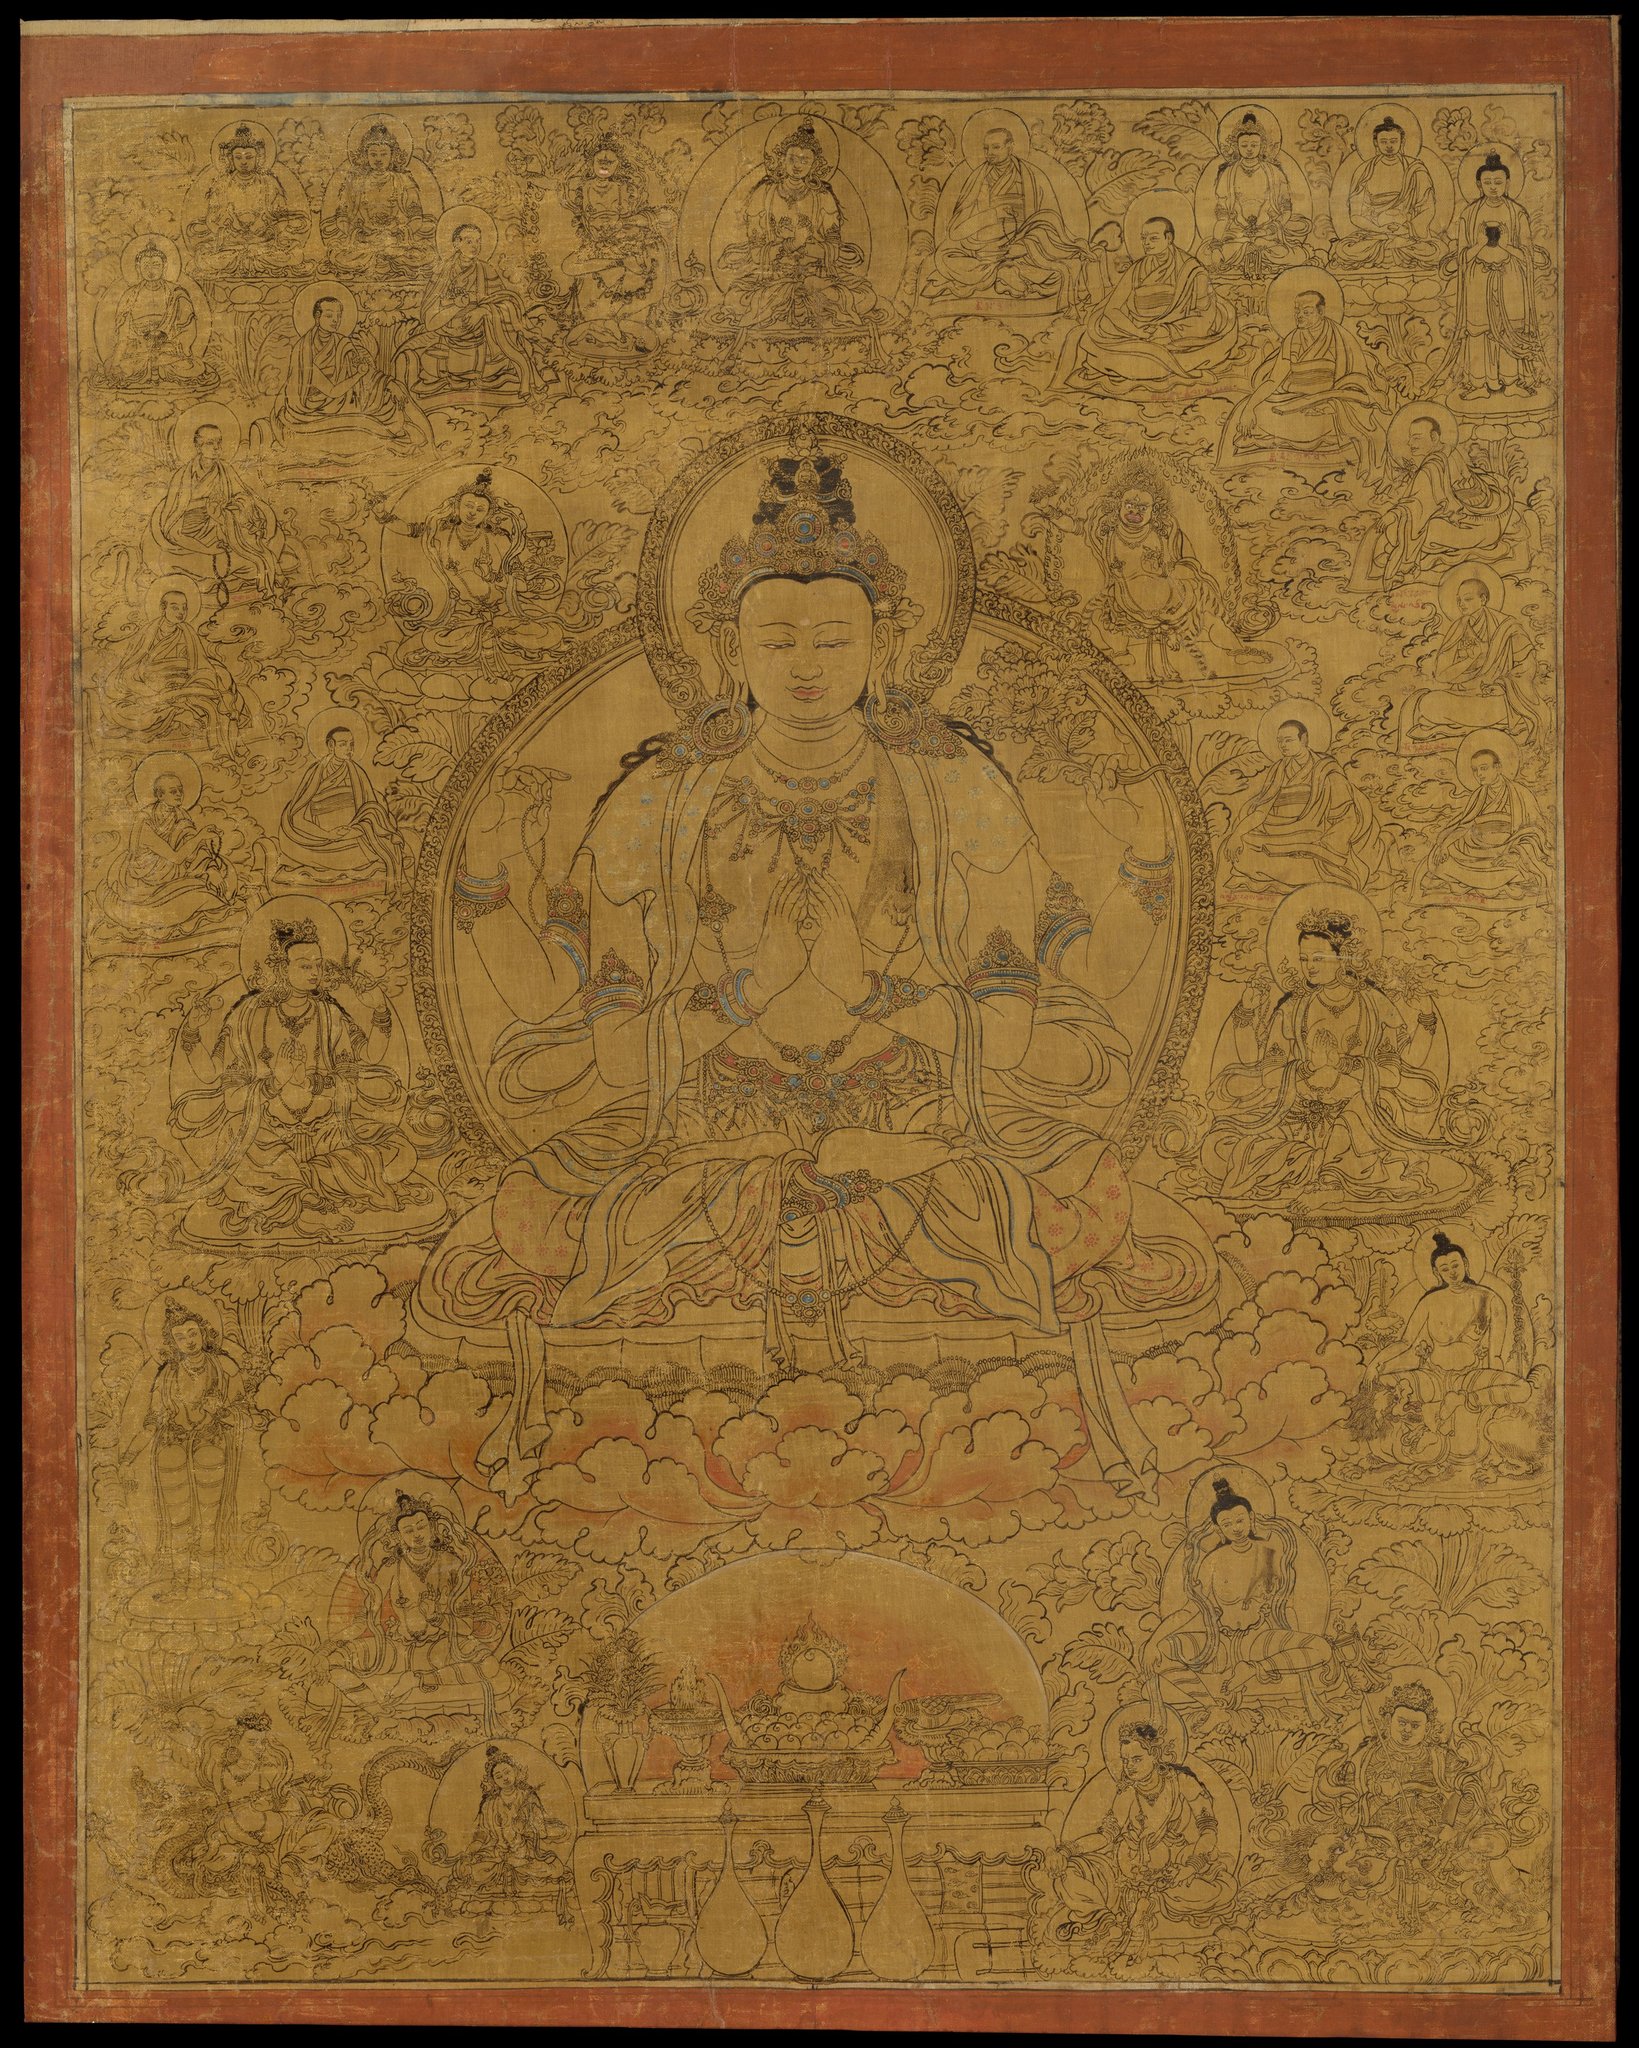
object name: painting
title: Sadaksari-Lokeshvara Surrounded by Manifestations and Monks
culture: tibetan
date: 1467-1500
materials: textile, gold, ink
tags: buddhism,avalokiteshvara,bodhisattvas,buddha,monks